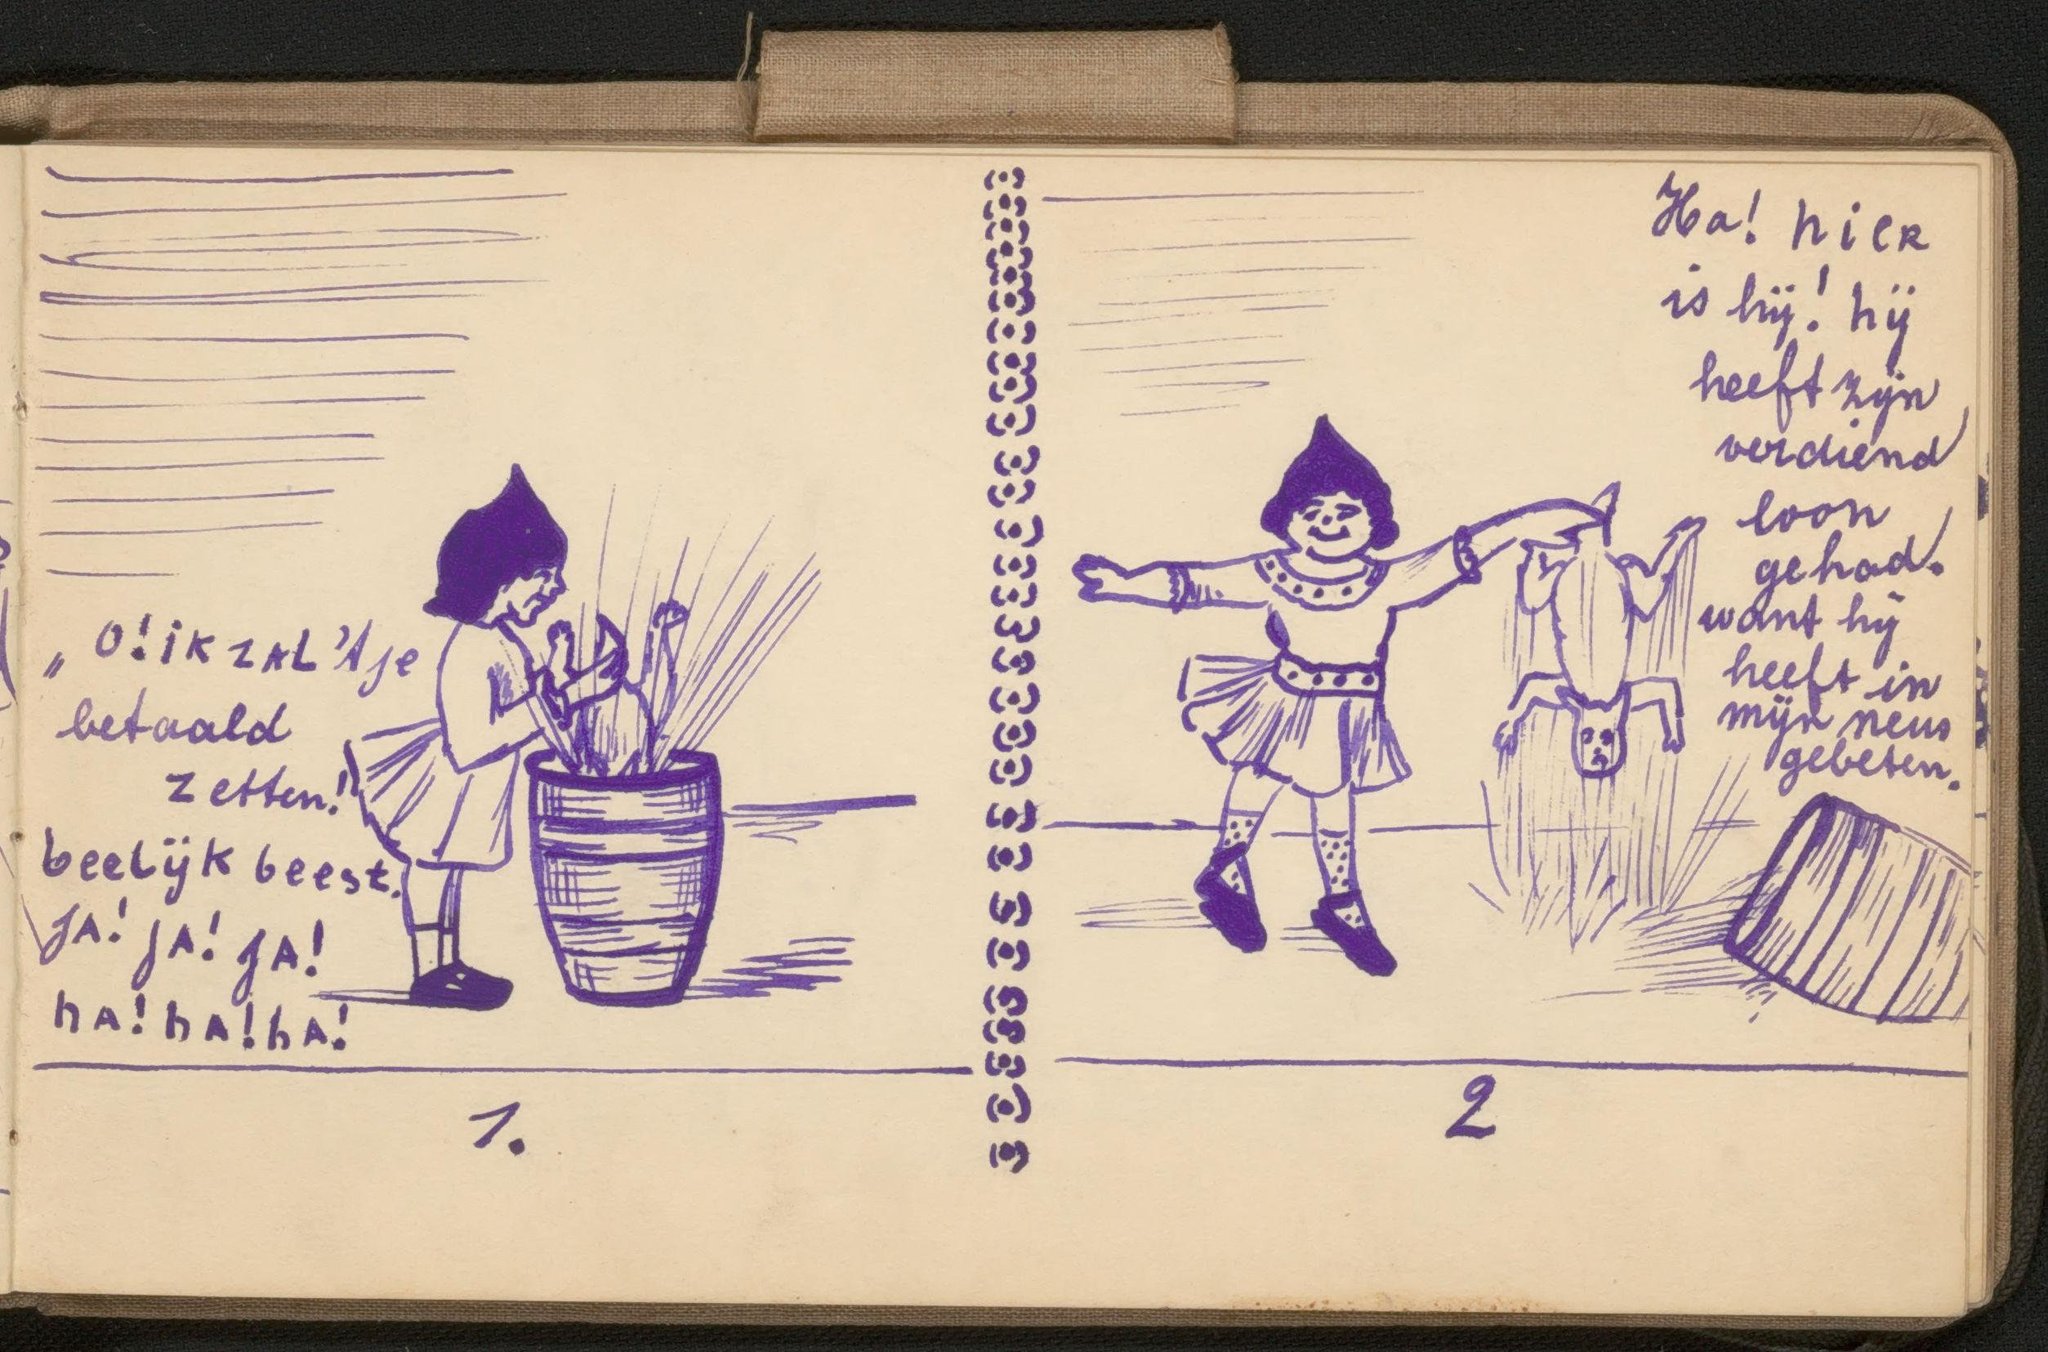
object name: sketchbook leaf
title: Lelijk beest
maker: Anonymous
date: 1875-1920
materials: ink, paper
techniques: pen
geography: netherlands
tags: dog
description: Een dochter straft de hond die haar in de neus had gebeten. Onderdeel van het schetsboek met humoristische tekeningen over het leven van een 'famille nombreuse'. Onderwerpsrubrieken binnen de Atlas Zeden en Gewoonten: Zeden en Gewoonten in Engeren Zin, Des menschen beging, midden en einde, Kinderleven.